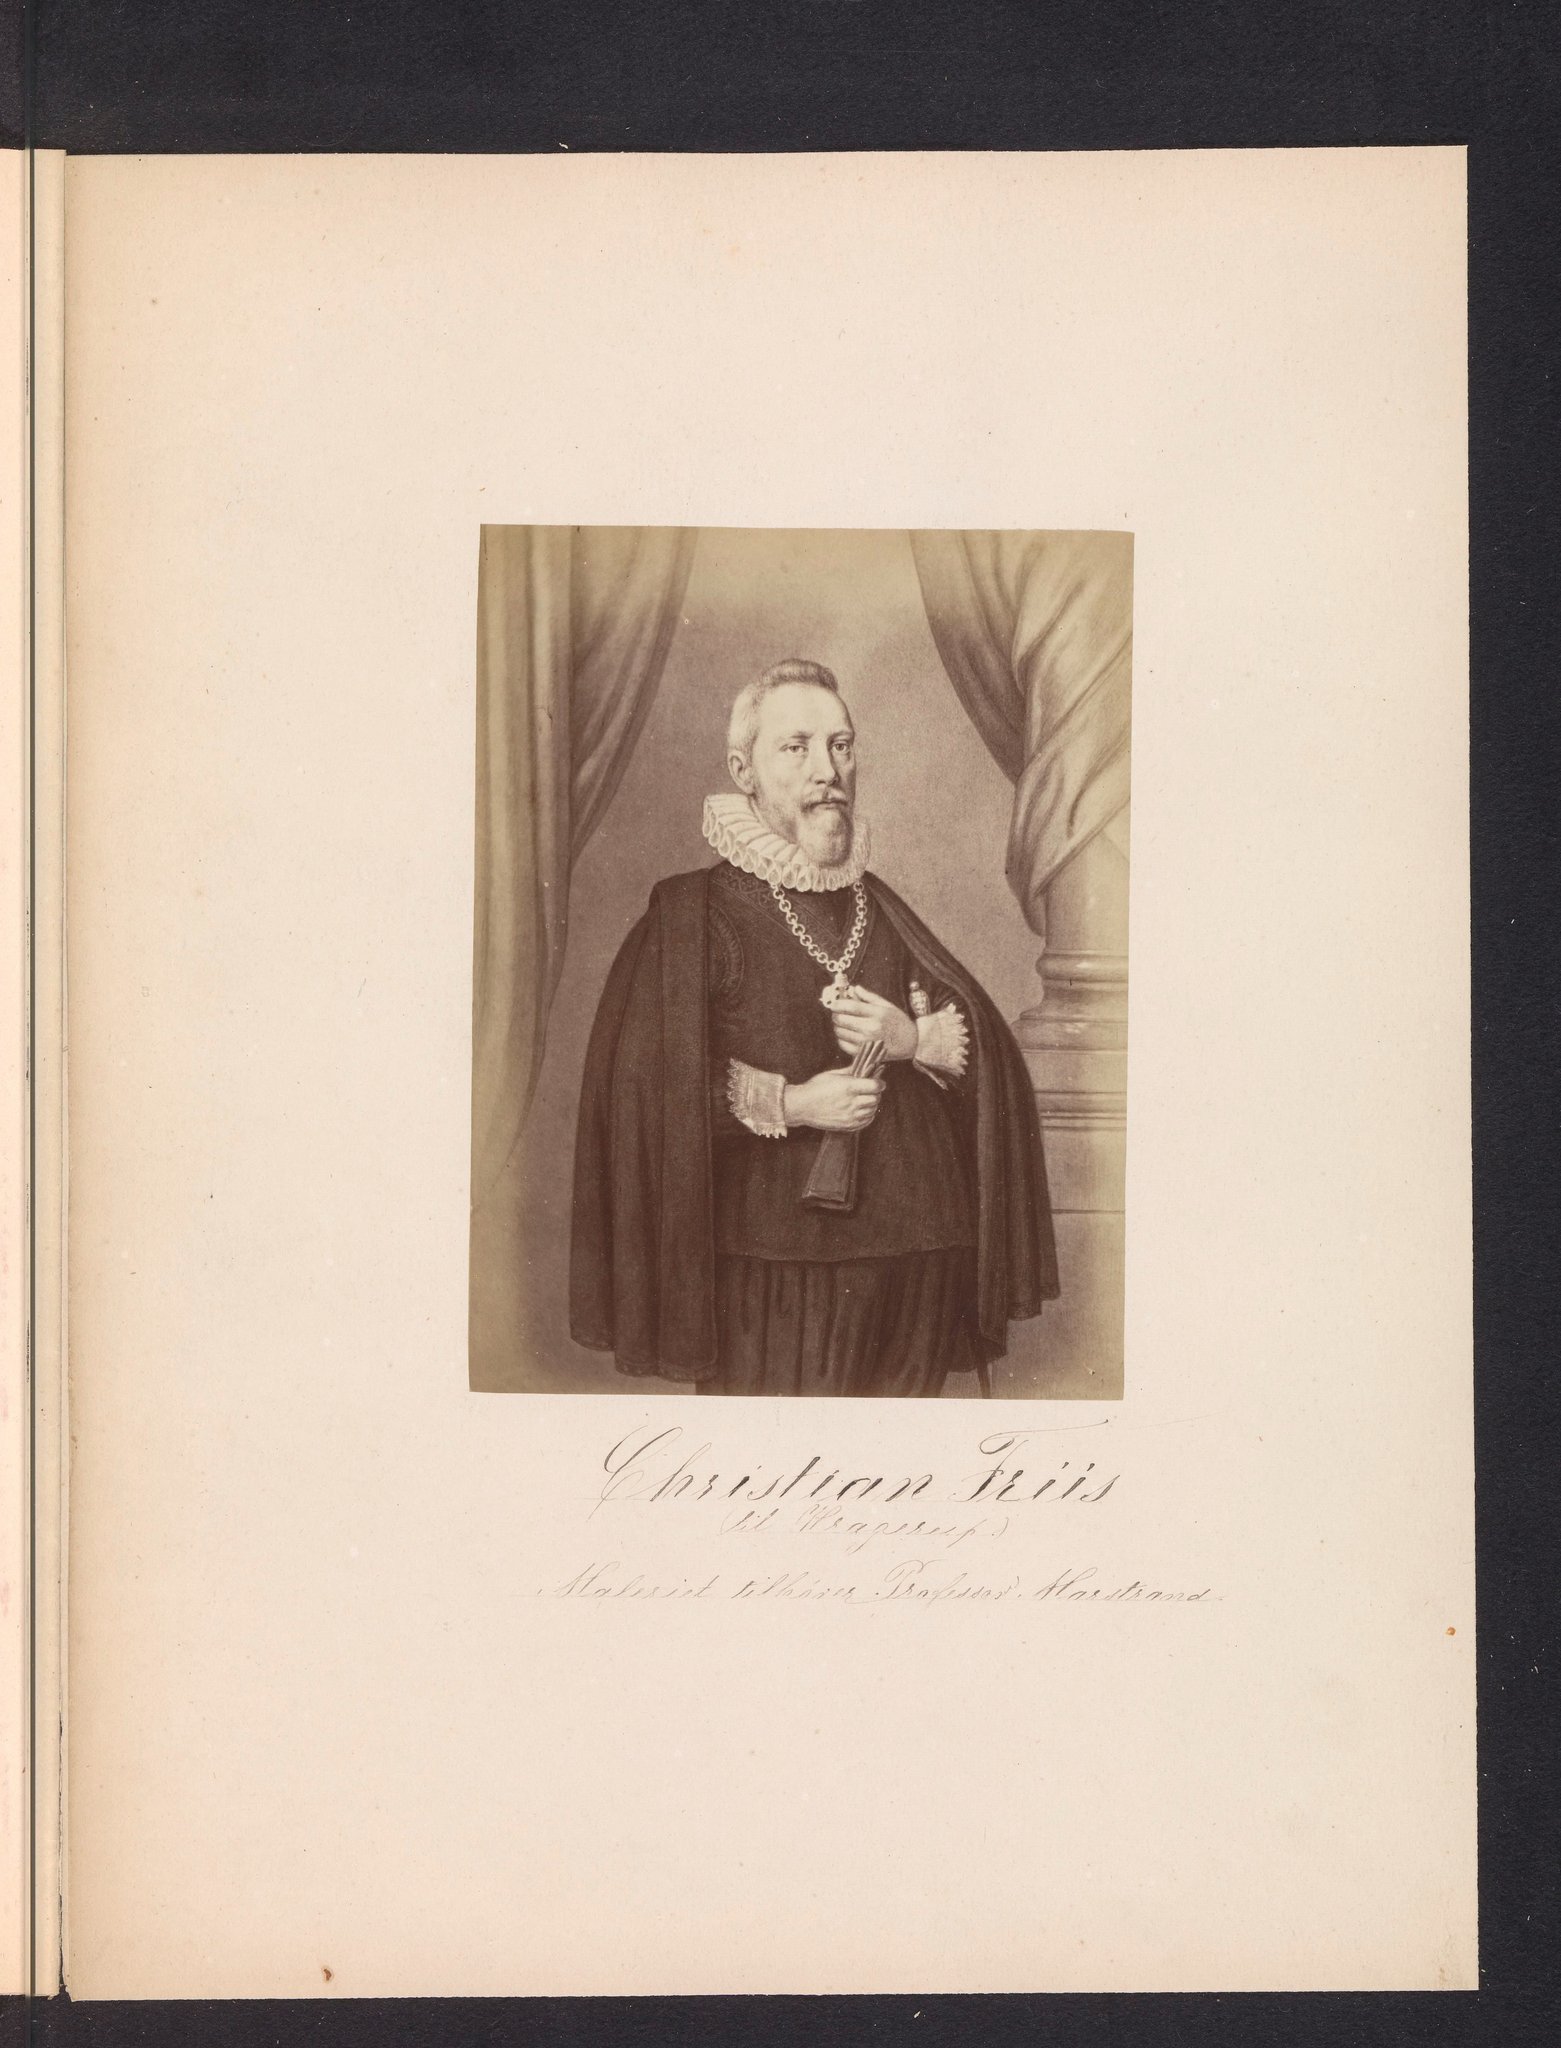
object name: page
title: Christian Friis (til Kragerup)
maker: julius wulff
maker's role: fotograaf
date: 1858-1862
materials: photographic support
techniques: albumen print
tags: official; civil servant; functionary (in general)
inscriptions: inscription: ‘Maleriet tillhører Professor Marstrand.’